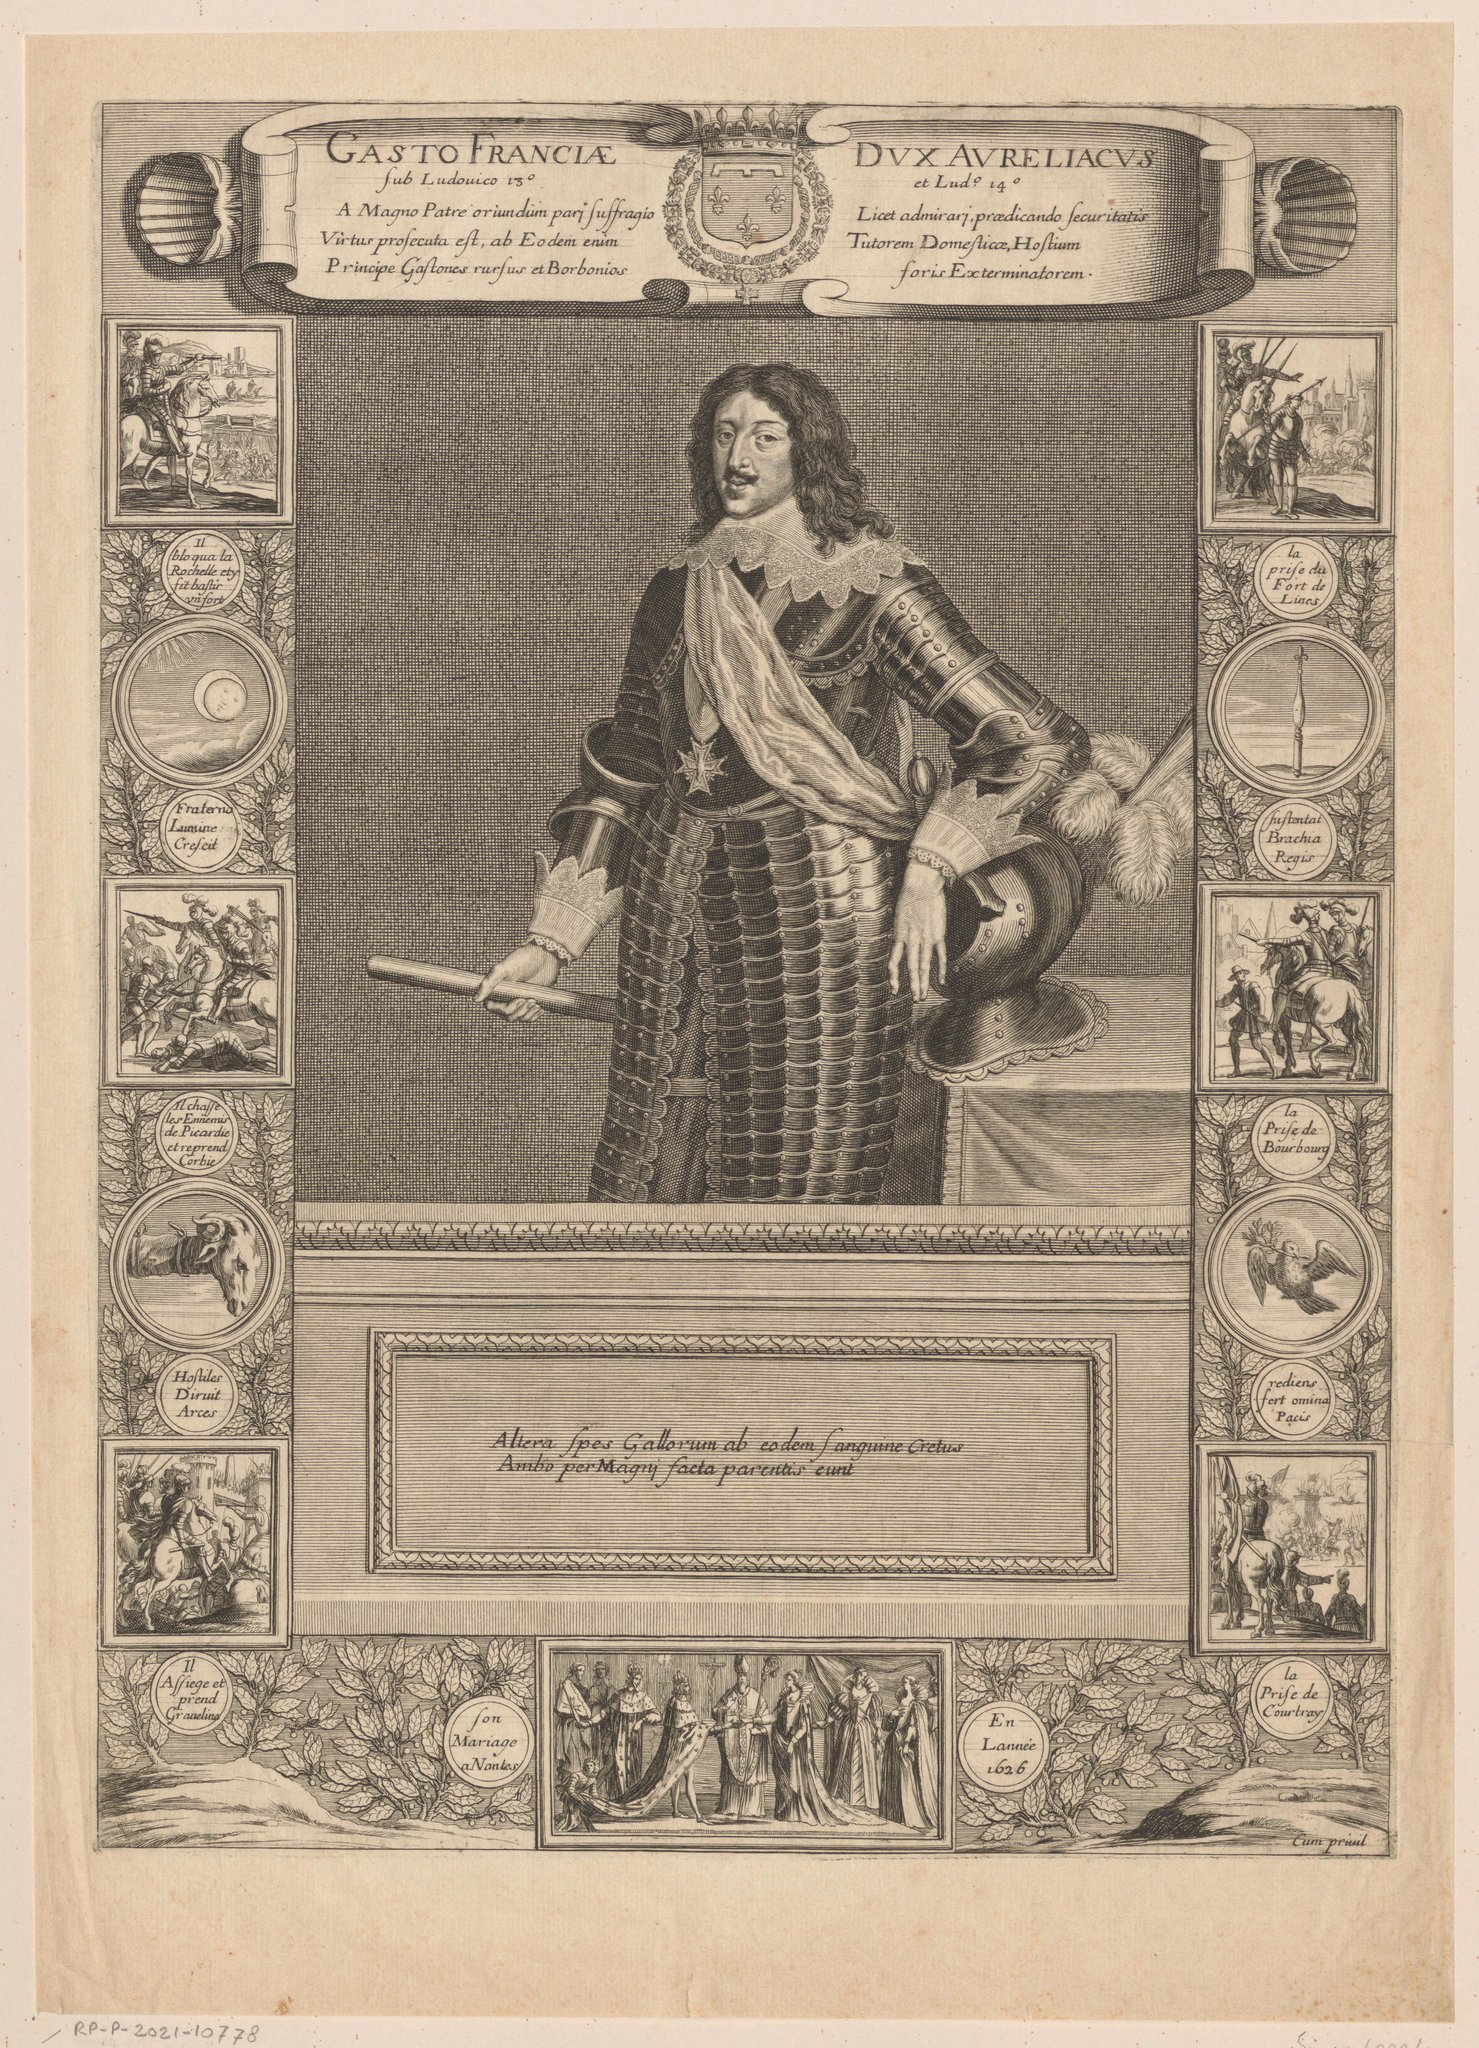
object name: print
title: Portret van Gaston Jean-Baptiste, hertog van Orléans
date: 1650-1690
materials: paper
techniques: engraving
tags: gaston jean-baptiste hertog van orléans, ram's head ~ ornament, historical persons, battle, trees: olive-tree, (civil) marriage ceremonies, armorial bearing, heraldry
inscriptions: collector's mark: Lugt 2228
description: Prent mogelijk uit: Vulson de La Colombière, Marc de. Les portraits des hommes illustres François qui sont peints dans la gallerie du Palais cardinal de Richelieu (...). Parijs: Henry Sara et al., 1650. Of uit latere publicaties (1655, 1662, 1690 en 1690).